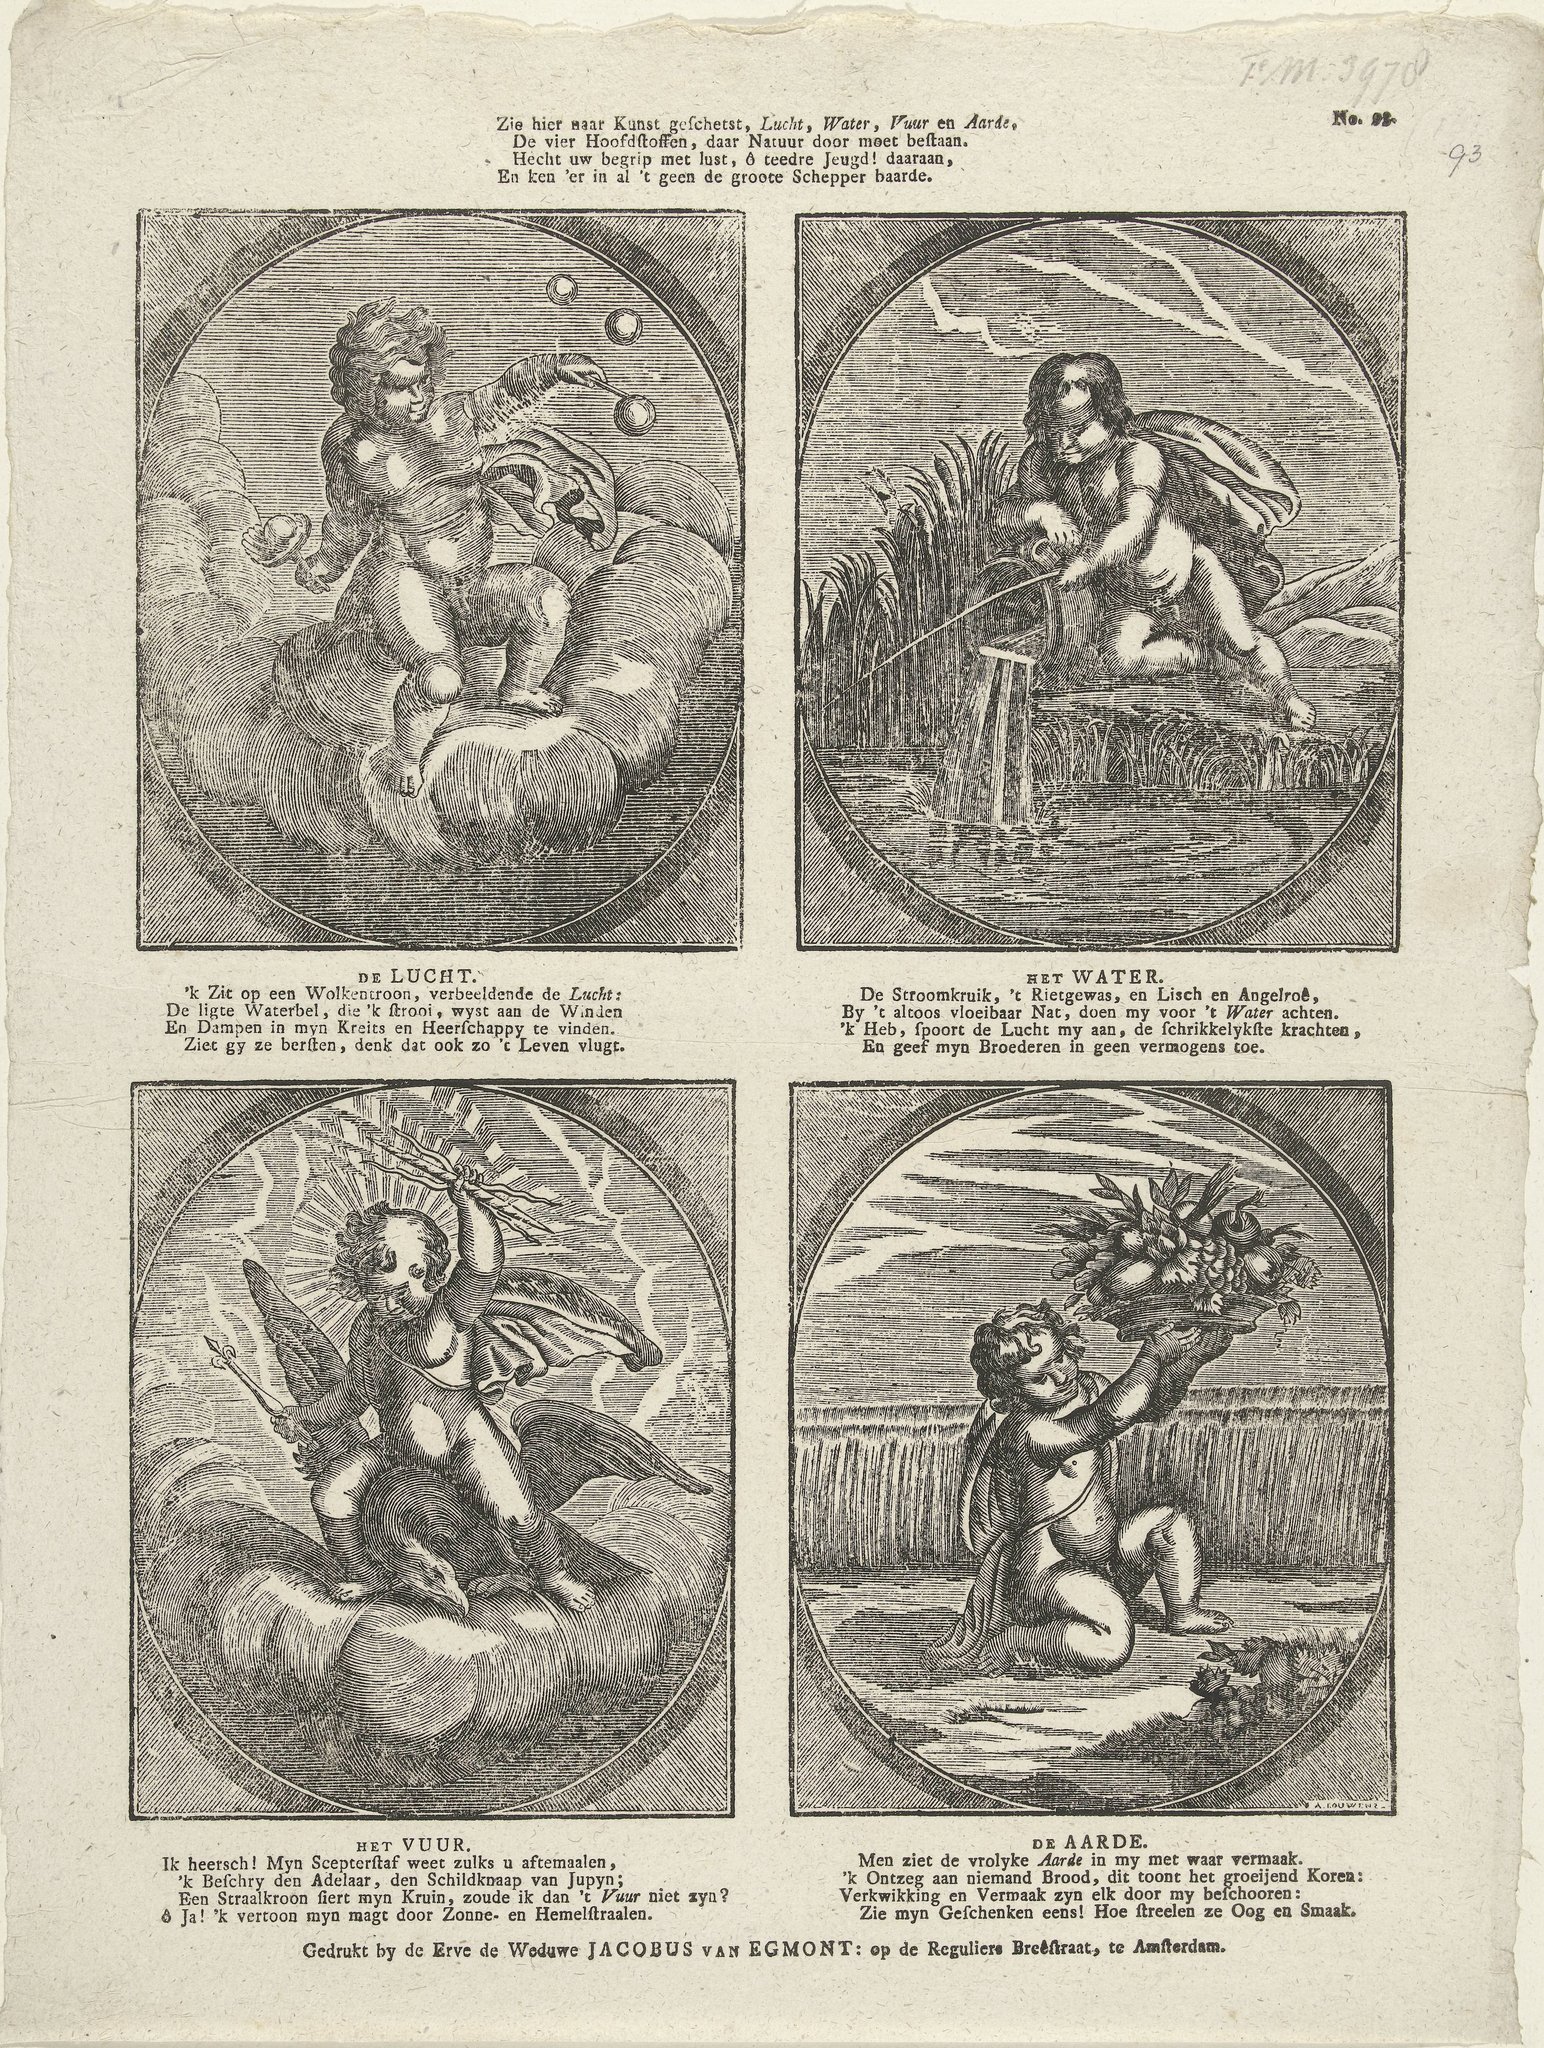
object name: print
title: Zie hier naar kunst geschetst, lucht, water, vuur en aarde, / De vier hoofdstoffen, daar natuur door moet bestaan; / Hecht uw begrip met lust, ô teedre jeugd! daaraan, / En ken 'er in al 't geen de groote schepper baarde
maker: a. bouwens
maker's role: bloksnijder, houtsnijder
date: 1761-1804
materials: paper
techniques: letterpress printing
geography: amsterdam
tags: the four elements, and ether, the fifth element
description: Blad met 4 voorstellingen van putti met attributen die de vier elementen symboliseren: lucht, water, vuur en aarde, in lijsten. Onder elke afbeelding een titel en vierregelig vers. Genummerd rechtsboven: No. 93.